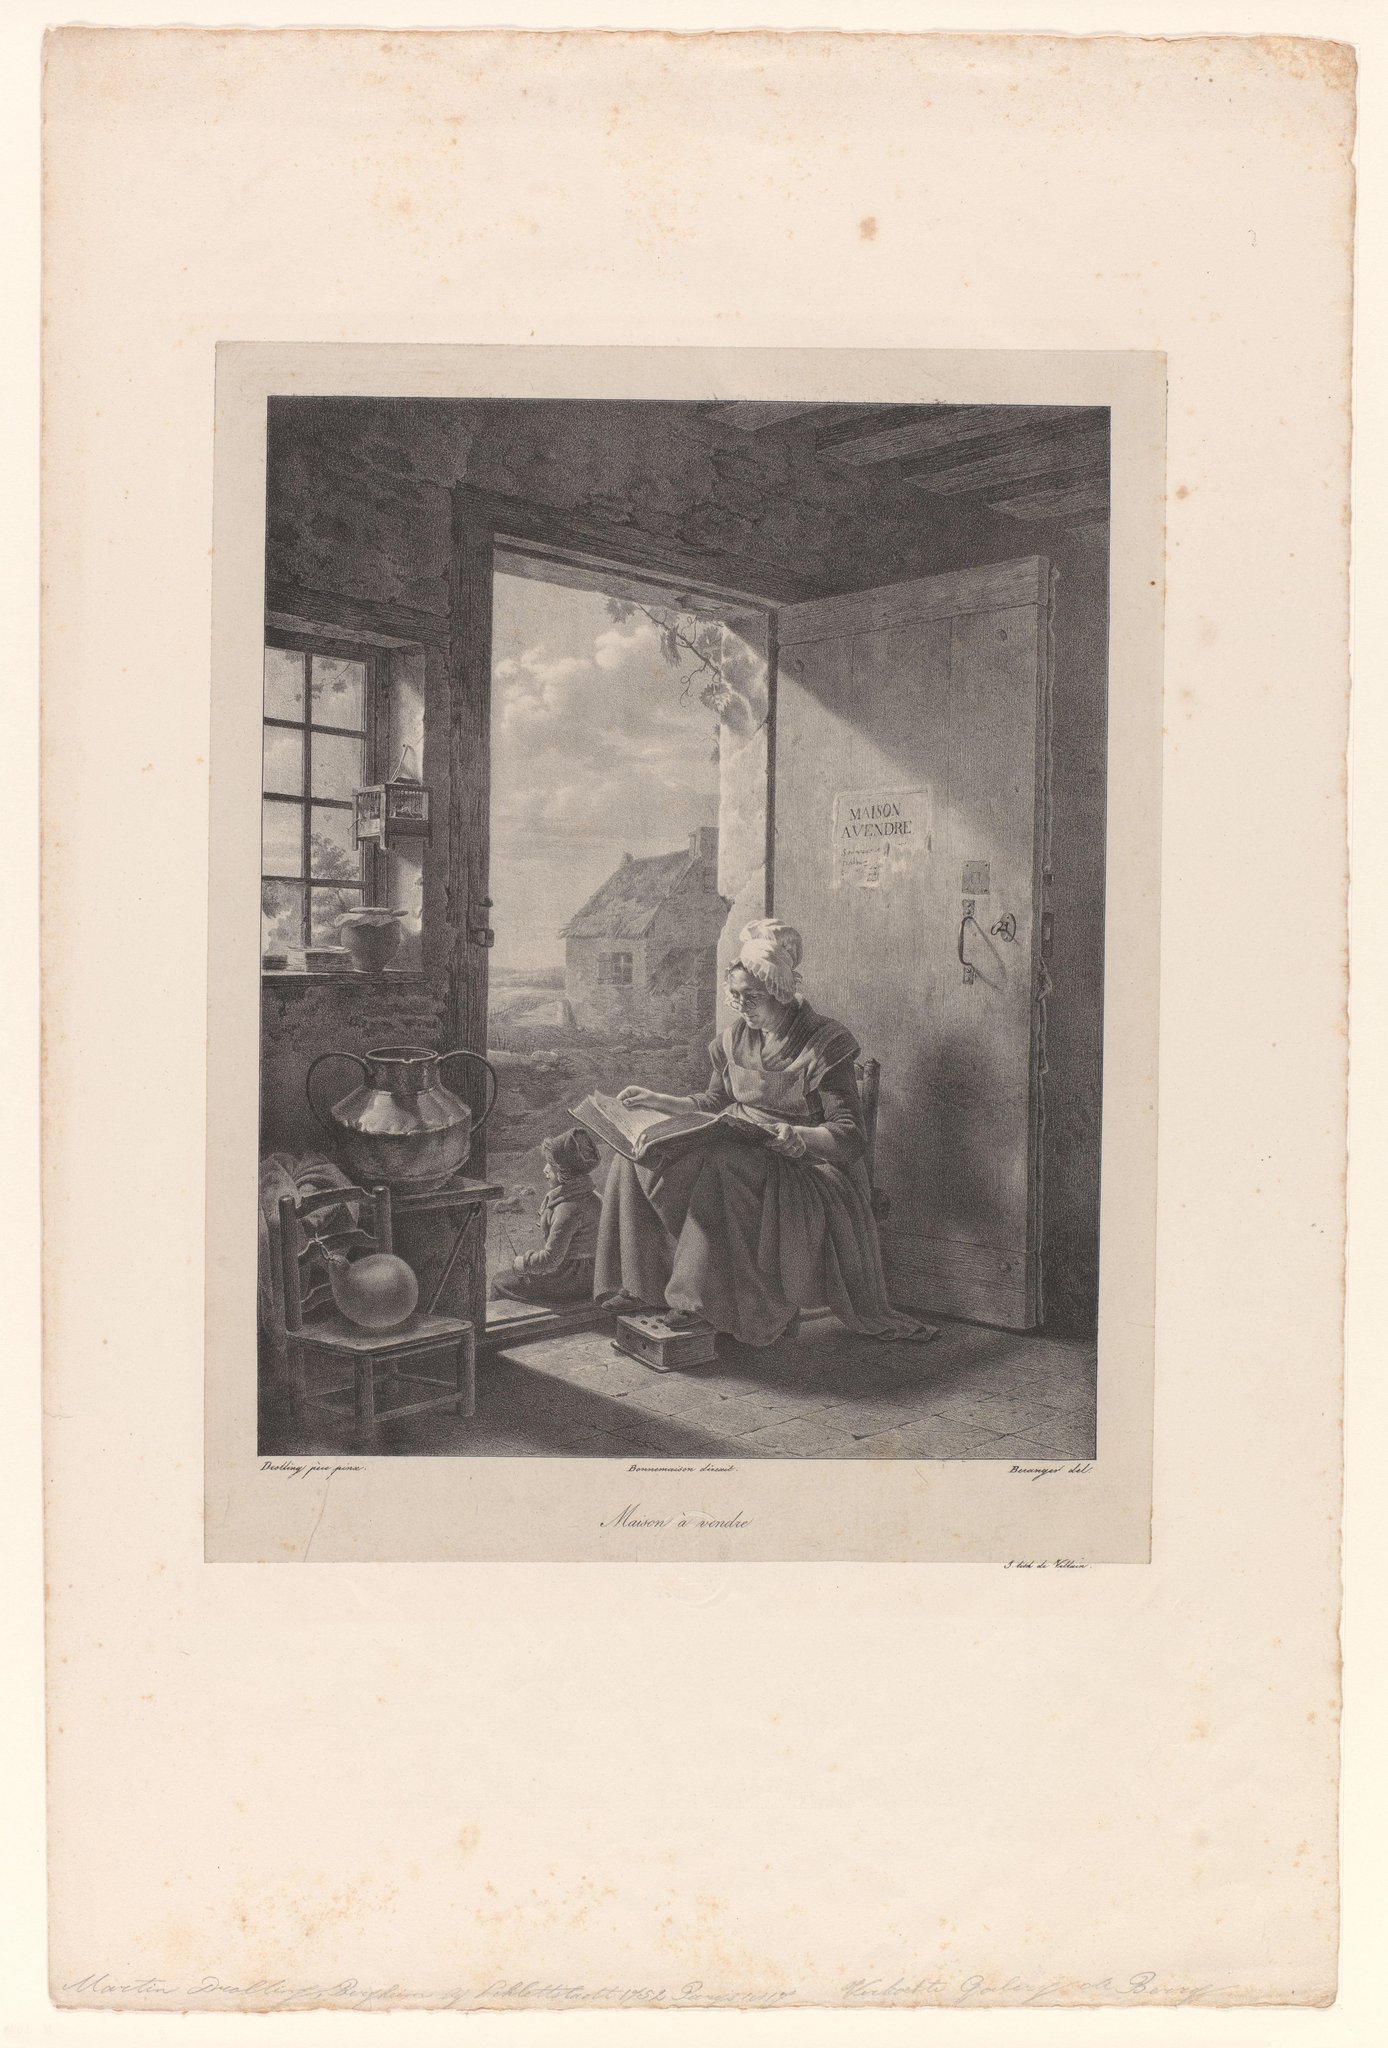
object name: print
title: Maison à vendre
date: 1822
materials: paper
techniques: lithograph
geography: paris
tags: adult woman, reading, open door, interior of the house, mother and child(ren), woman and child(ren) (family group)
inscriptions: collector's mark: Lugt 2228a, check stamp: Lugt 4729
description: Volgens het papier dat op de deur is geplakt, staat het huis te koop.